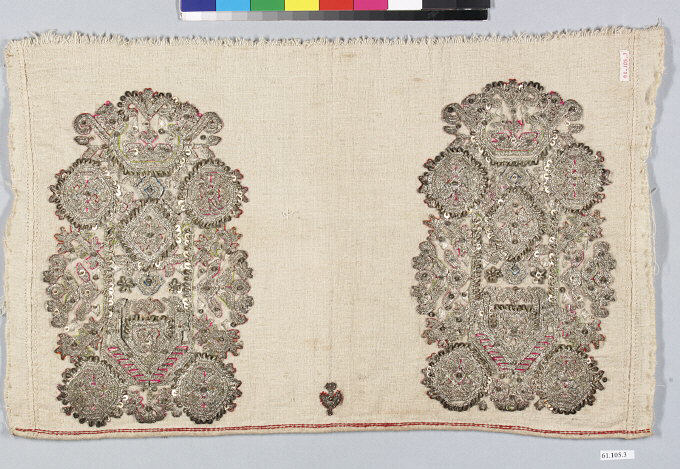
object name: piece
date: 1801-1900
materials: cotton, metal thread, wool